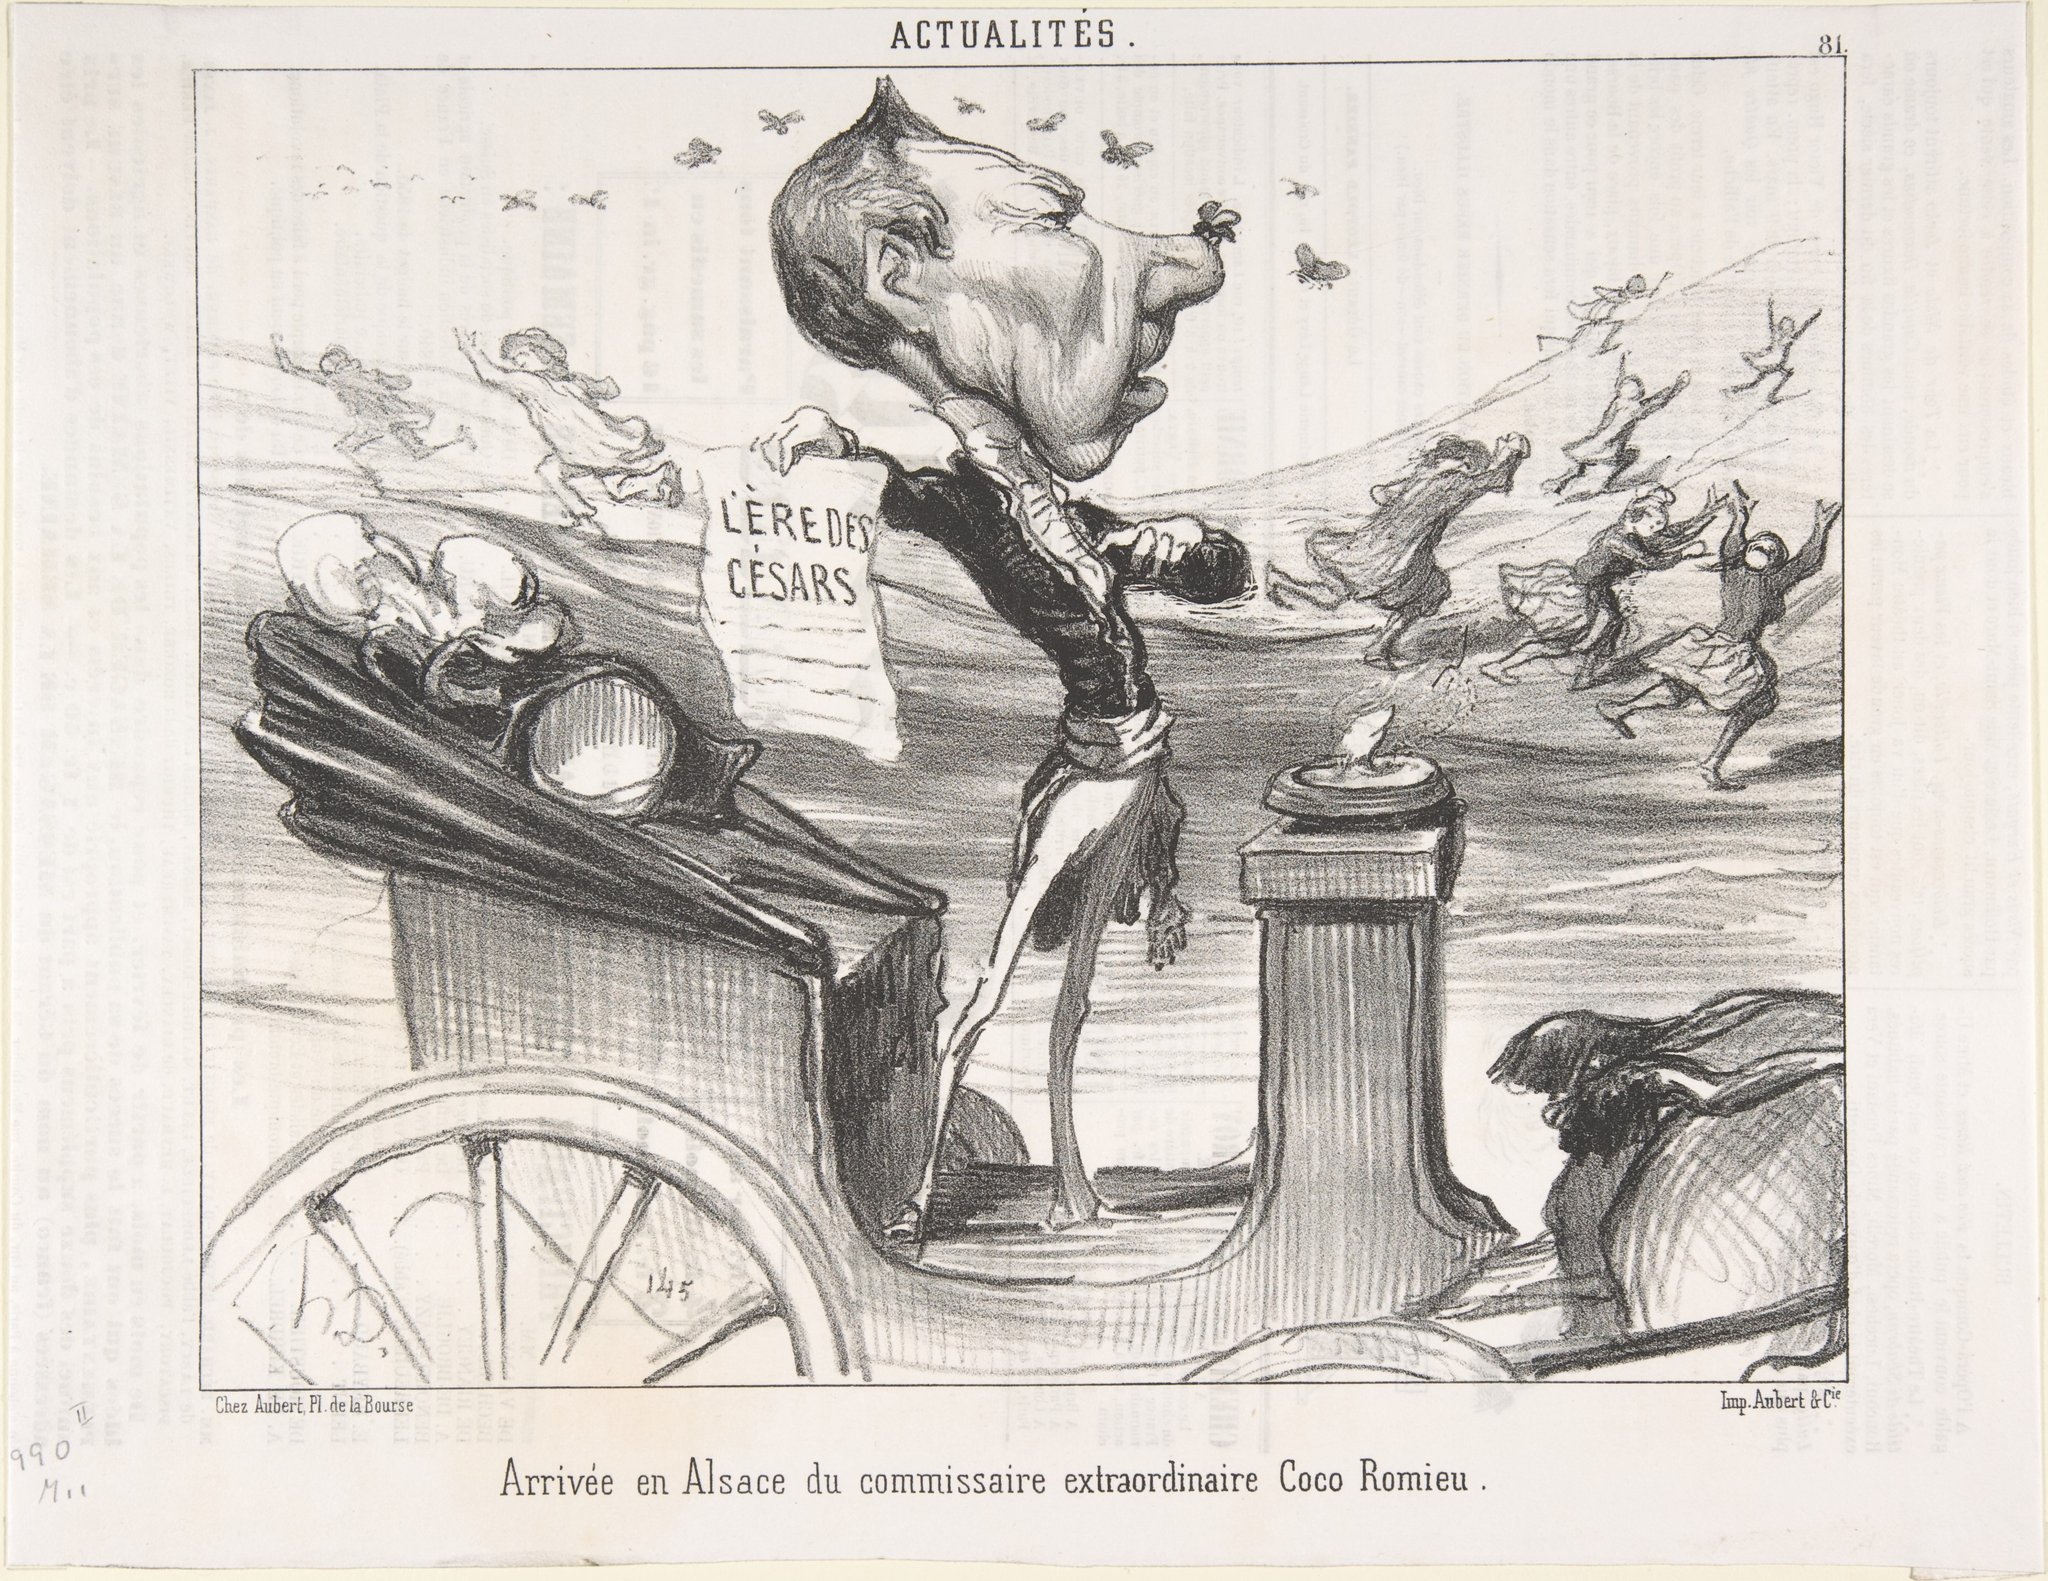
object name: print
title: Arrivée en Alsace du commissaire extraordinaire Coco Romieu, published in Le Charivari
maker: honoré daumier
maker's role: artist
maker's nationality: french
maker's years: 1808-1879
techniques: lithograph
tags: men,carriages,caricature